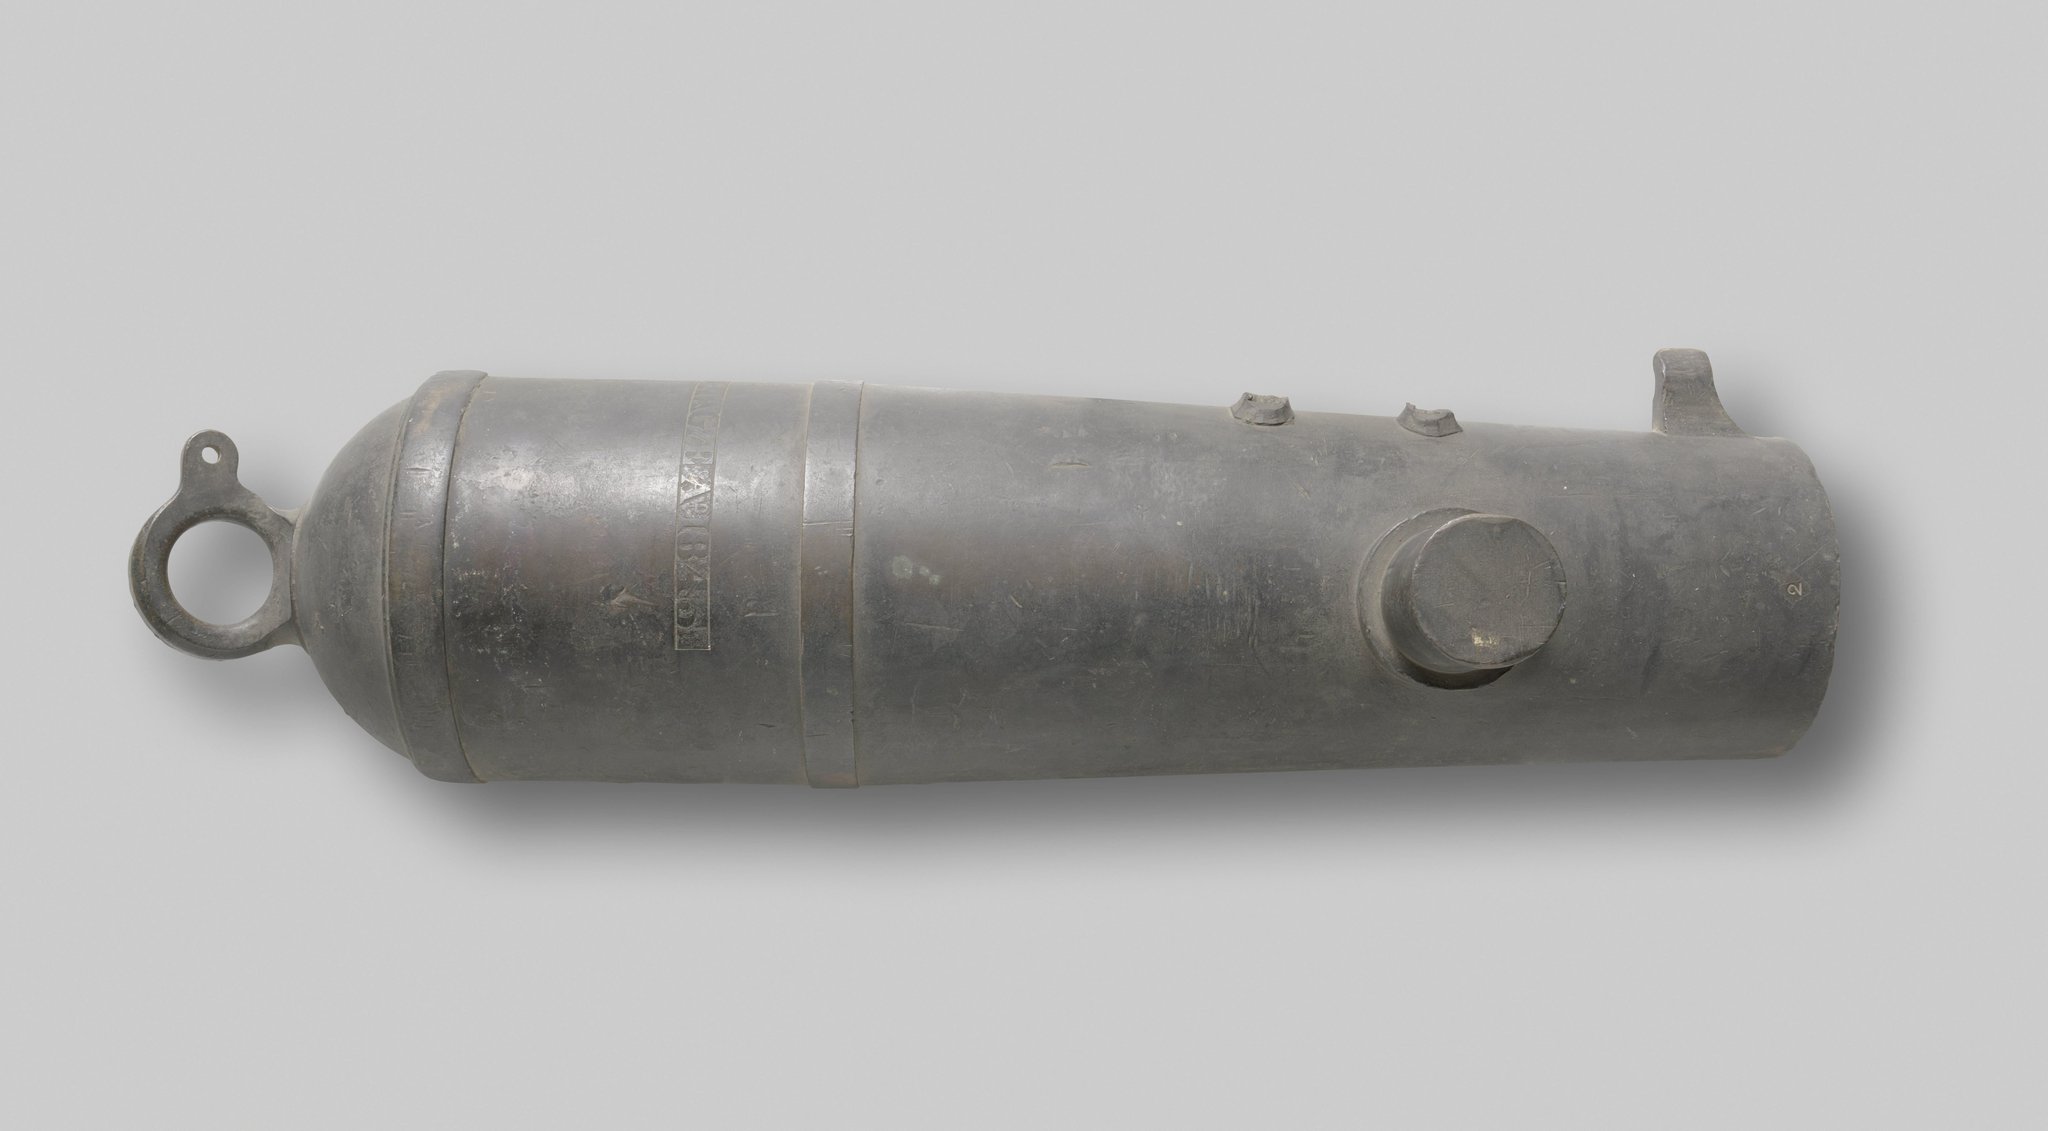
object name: cannon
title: Bronzen voorlaadkanon, deel rechtsachter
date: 1845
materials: bronze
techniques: casting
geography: the hague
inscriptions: signature and date: ‘.C HAGÆ A° 1845’, mark: ‘2’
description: Deel rechtsachter van lengtedoorsnede van voorlader. Ringvormige druif met nok erop, iets verbogen. In de nok zit een gat. Zundgat met rechthoekige uitsparing. In de stootbodem (achter zundgat) gat met schuin naar voren lopende gleuf. Gieterijmerk tussen kulasband en eerste breuk. Wapen voor eerste breuk en tap. Basis van (afgebroken) dolfijn is nog zichtbaar. Voor de tap (1 stuk) bovenop de loop zit een nok. De loop is over de gehele lengte niet geboord. Op de loop (tussen eerste band en tap) gegraveerd het rechterdeel van gekroond wapen opgebouwd van bladeren en de letter W.